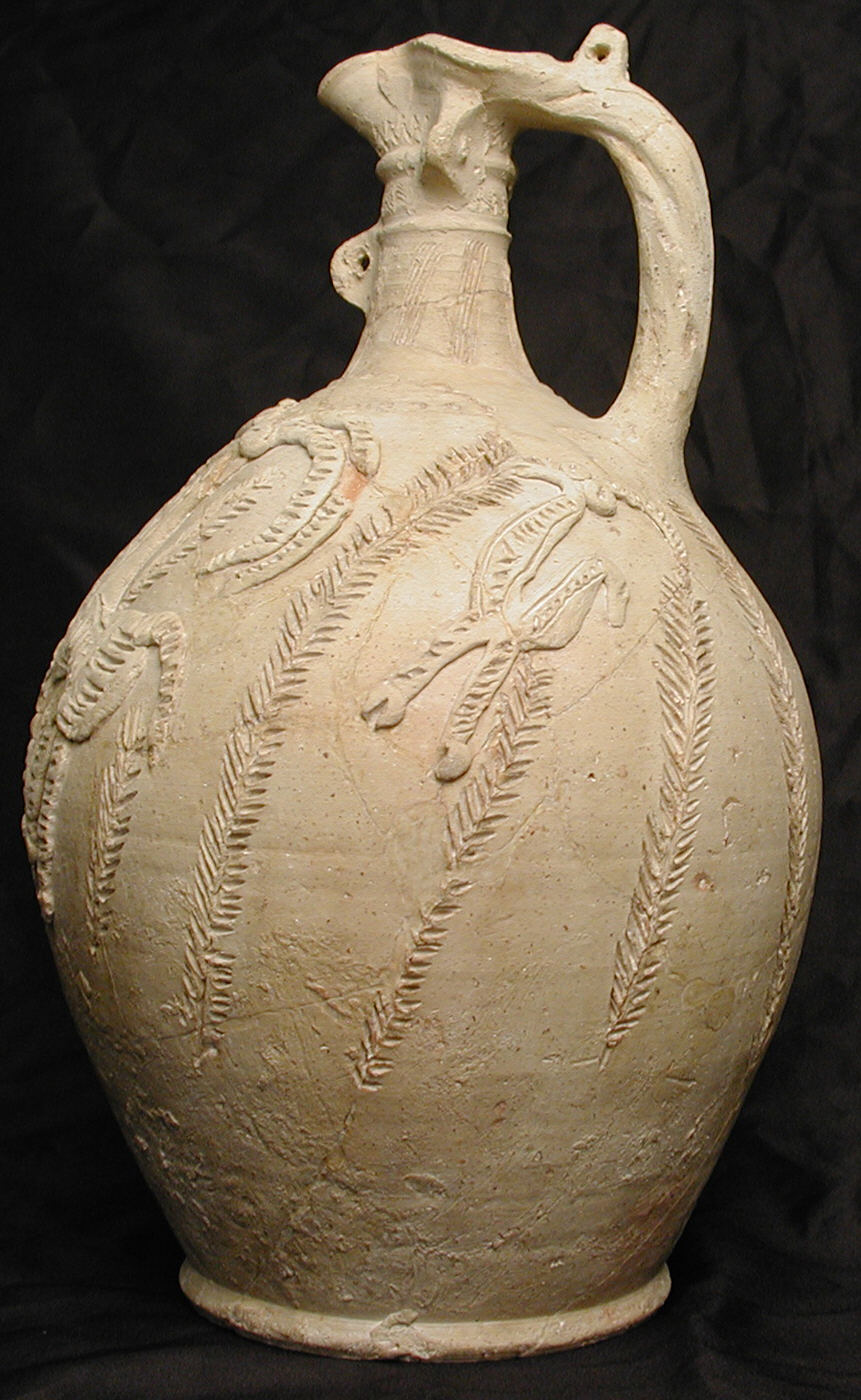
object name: ewer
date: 801-900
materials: earthenware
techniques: incising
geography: iran